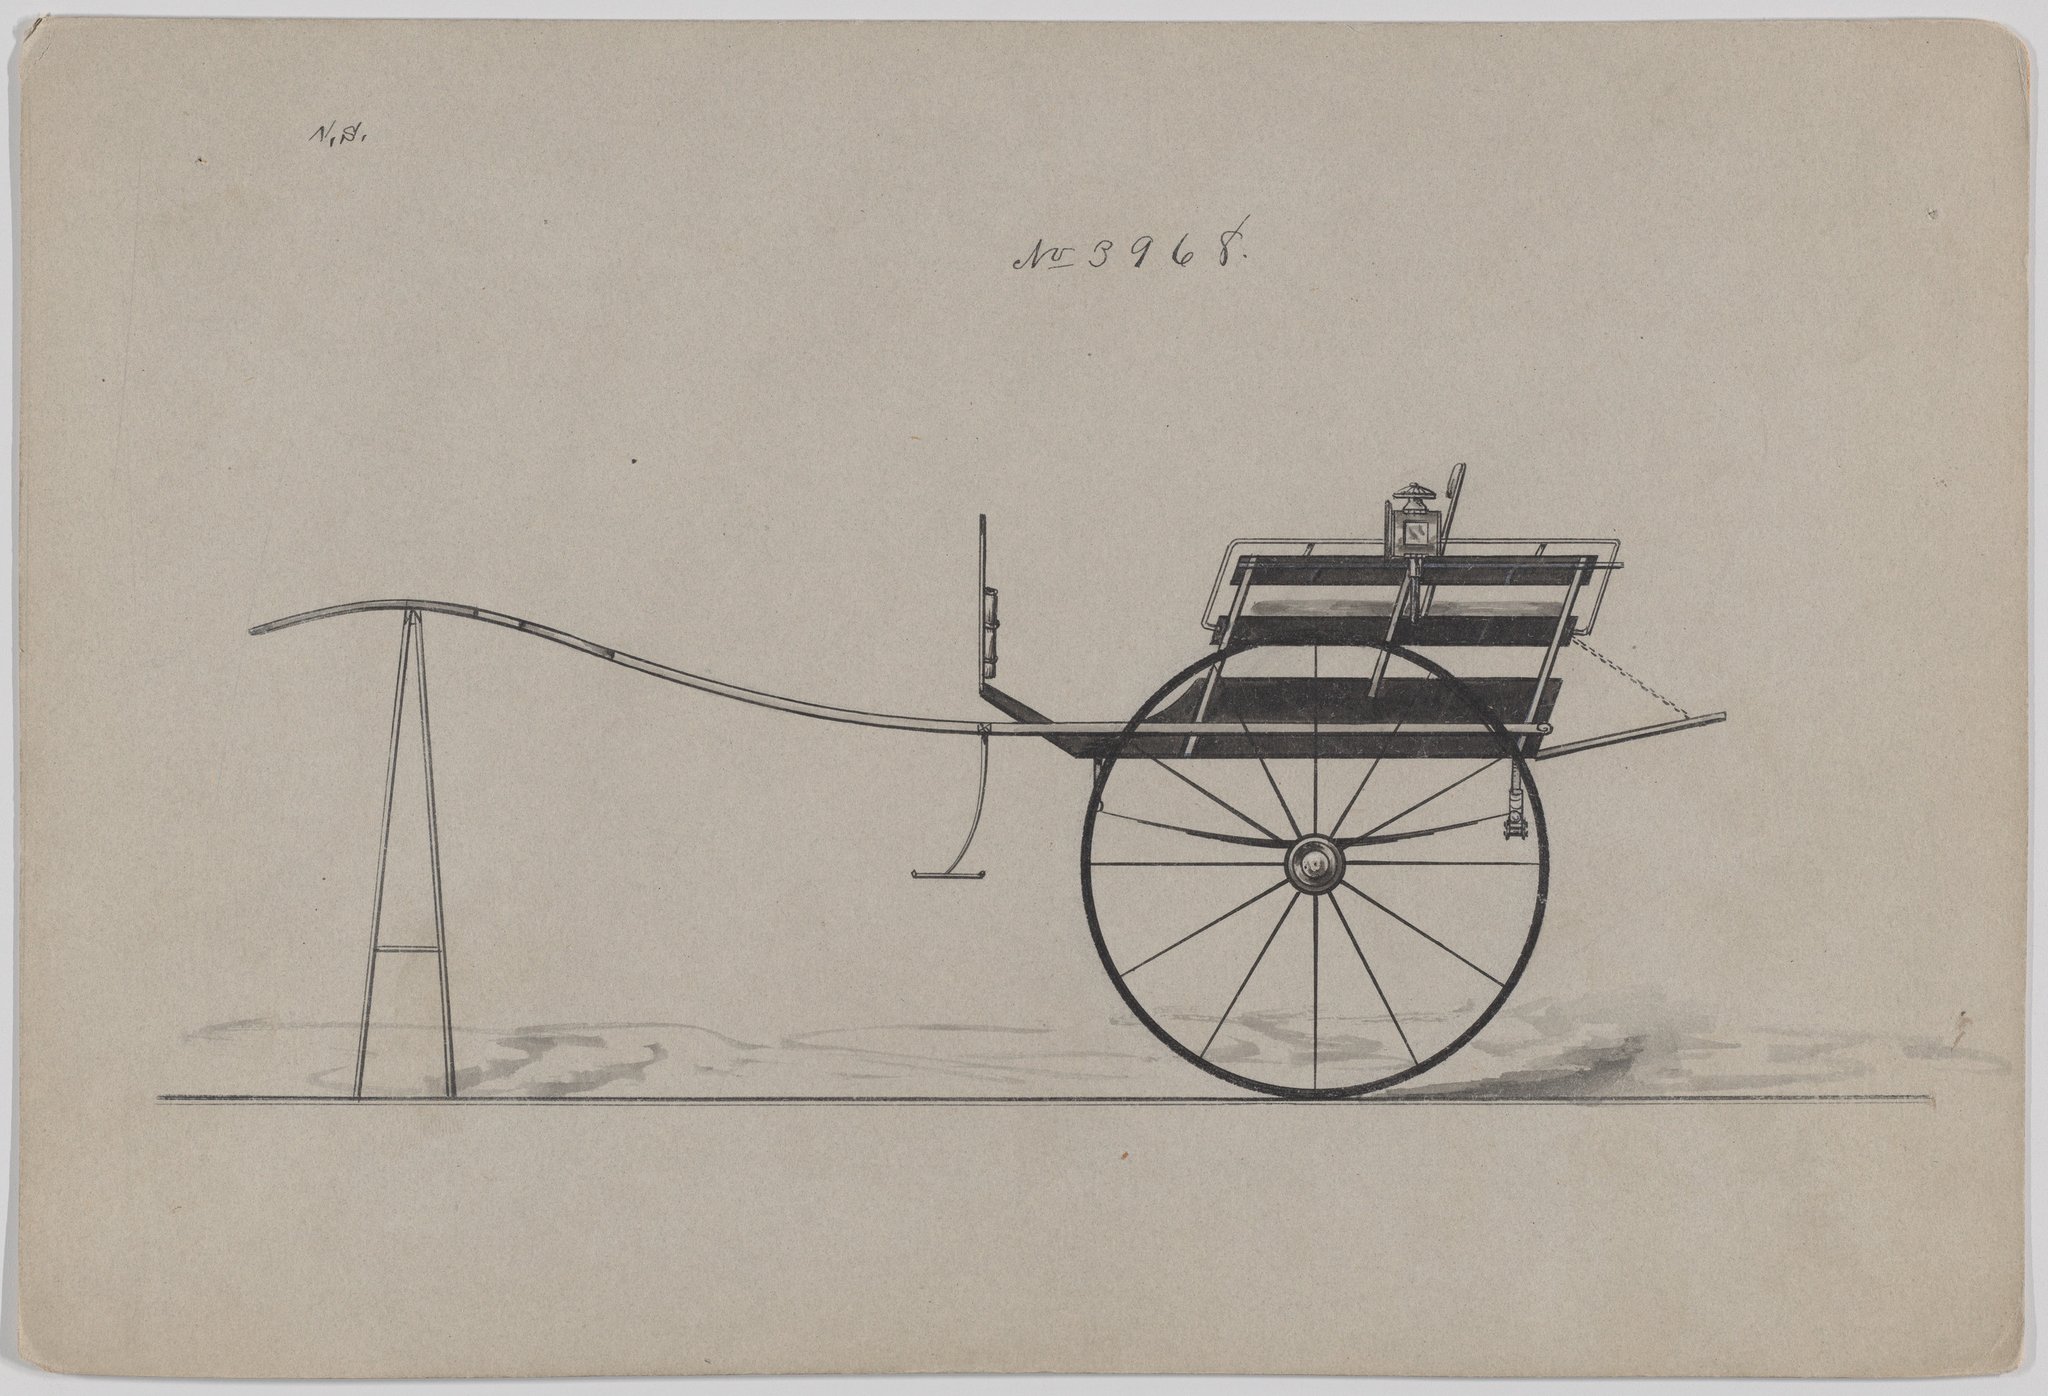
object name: drawing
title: Design for Dog Cart or 2 Wheeler, no. 3968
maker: brewster & co.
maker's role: manufacturer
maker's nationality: american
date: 1886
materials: ink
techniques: pen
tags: carriages